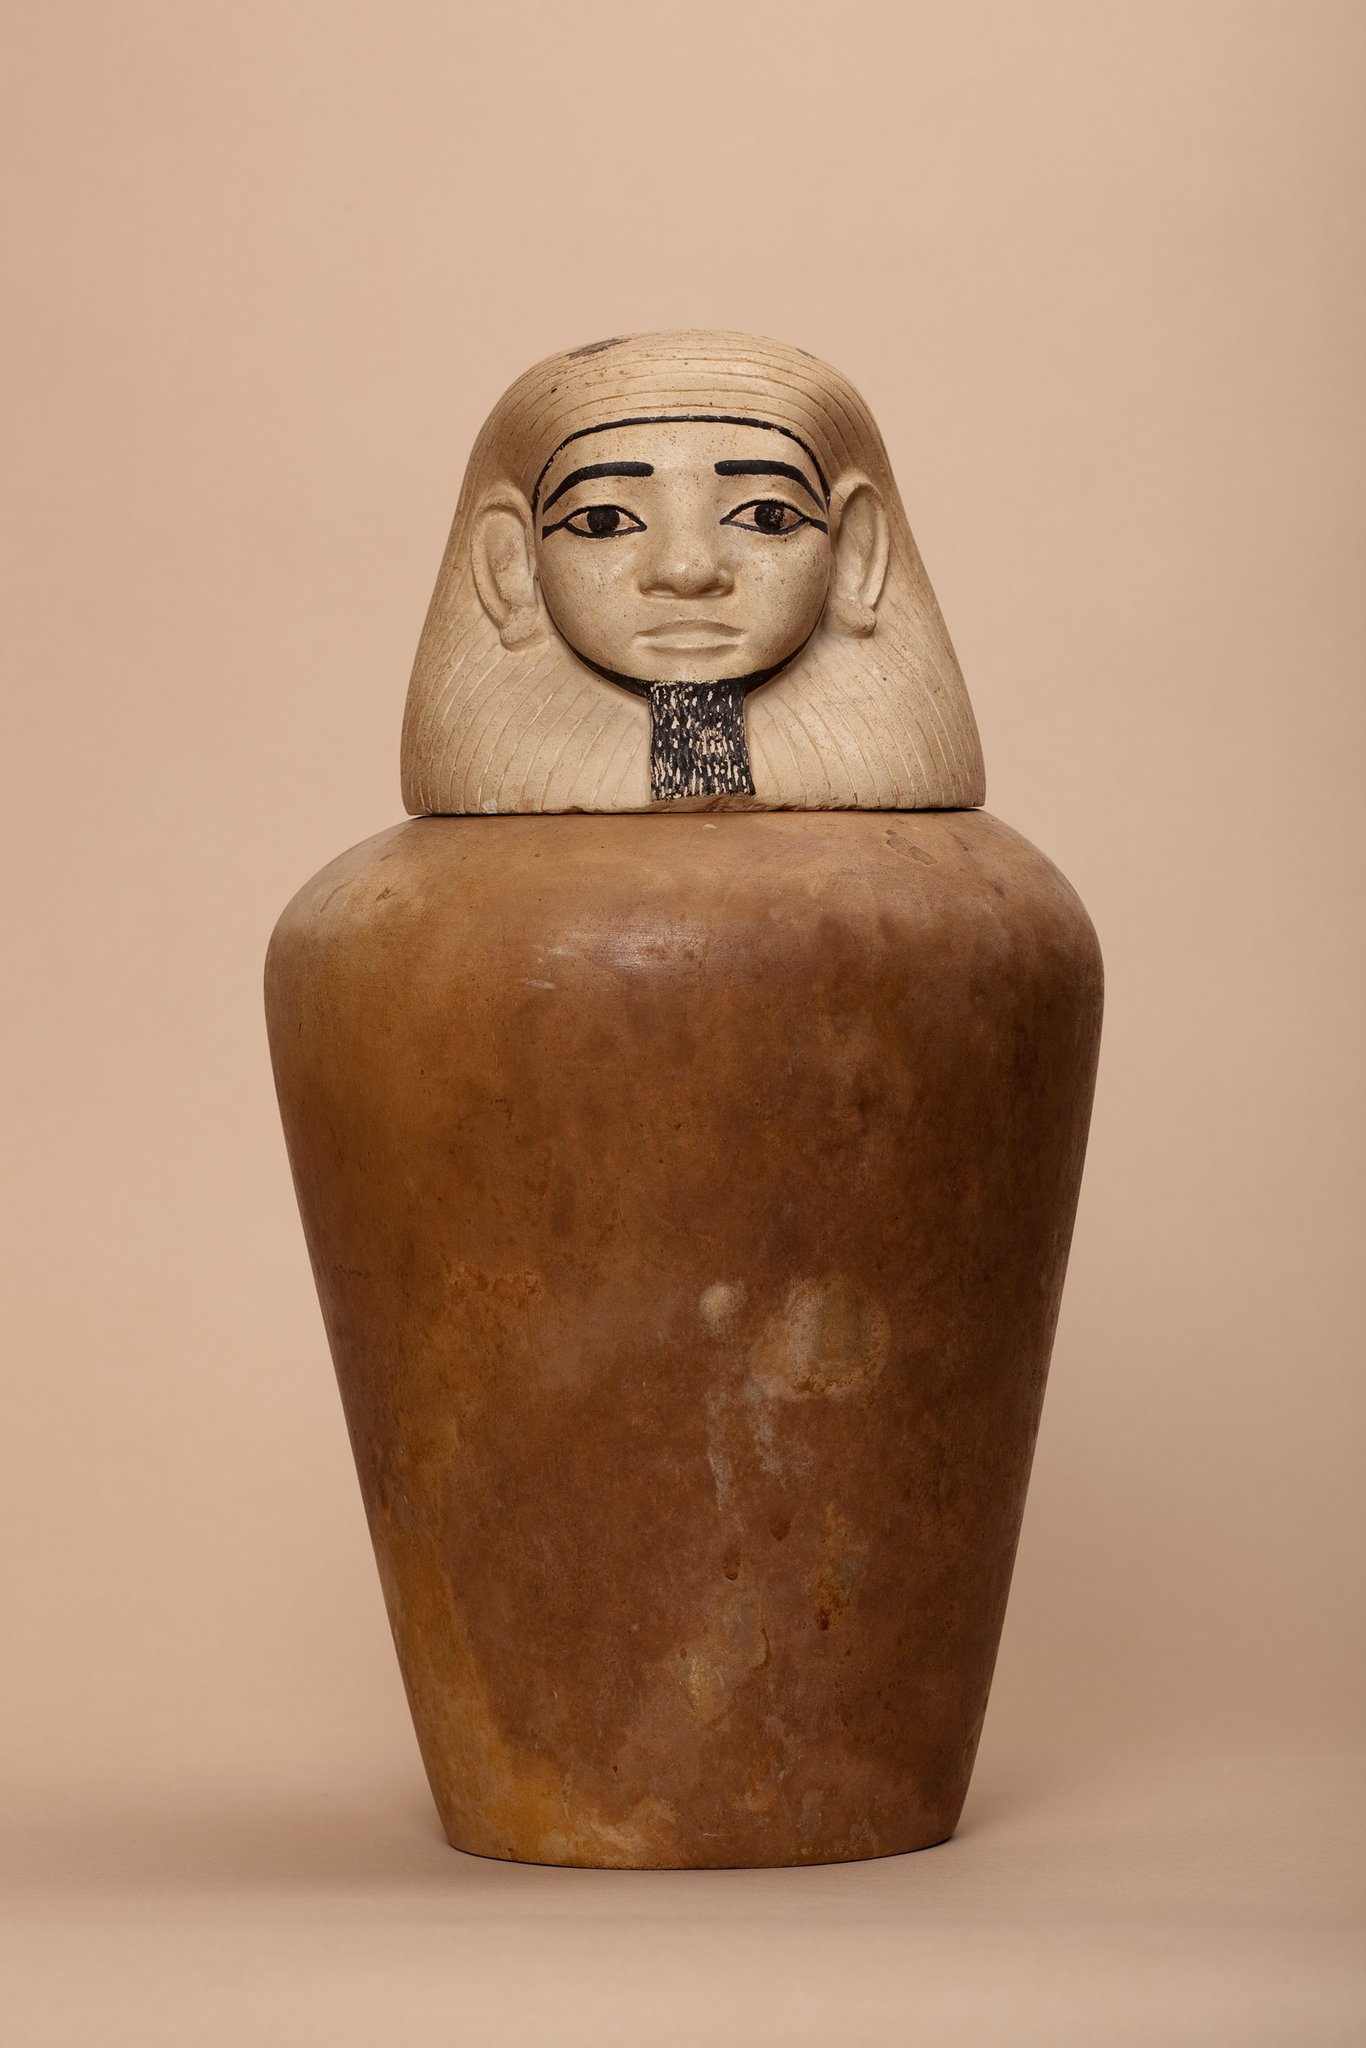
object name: canopic jar, nephthys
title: Canopic jar of Nephthys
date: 1981-1802 BCE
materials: limestone, linen, paint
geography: egypt